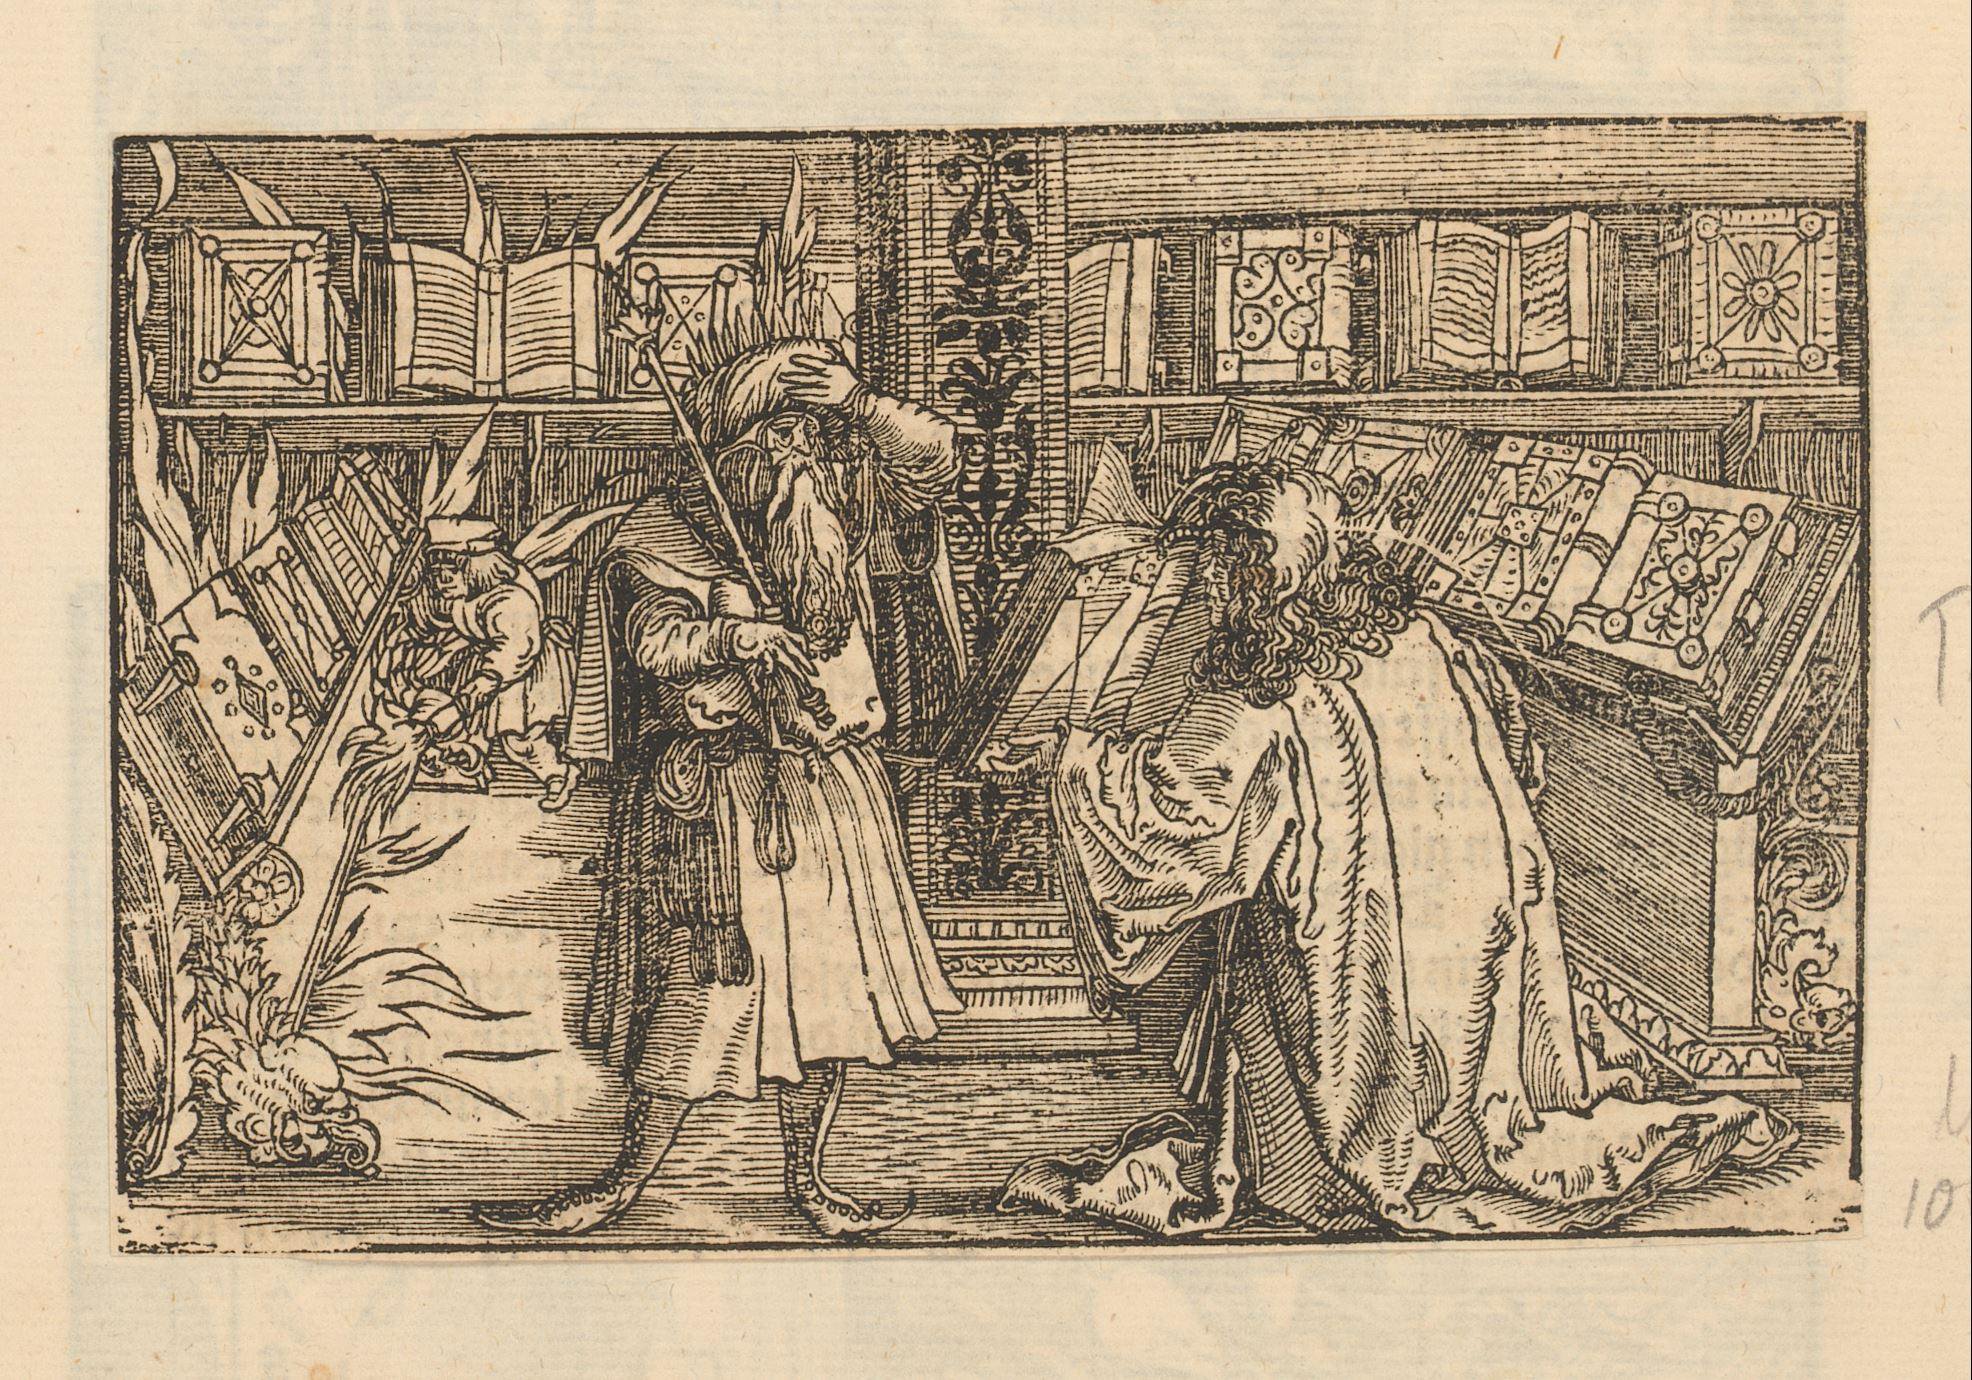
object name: print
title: Heerser is overweldigd door een boek dat hem getoond wordt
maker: Anonymous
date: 1514-1532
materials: paper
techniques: letterpress printing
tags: stirring up a fire, ornament ~ candelabrum, study; 'studiolo'; library, wise men versus fools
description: Deze prent is gebruikt in: Petrarca, Francesco. Von der Artzney bayder Glück, des guten und widerwertigen: unnd weß sich ain yeder inn Gelück und Unglück halten sol (...). Augsburg: Heinrich Steiner, 1532. Deze uitgave is ook bekend onder de titel 'Trostspiegel in Glück und Unglück'.